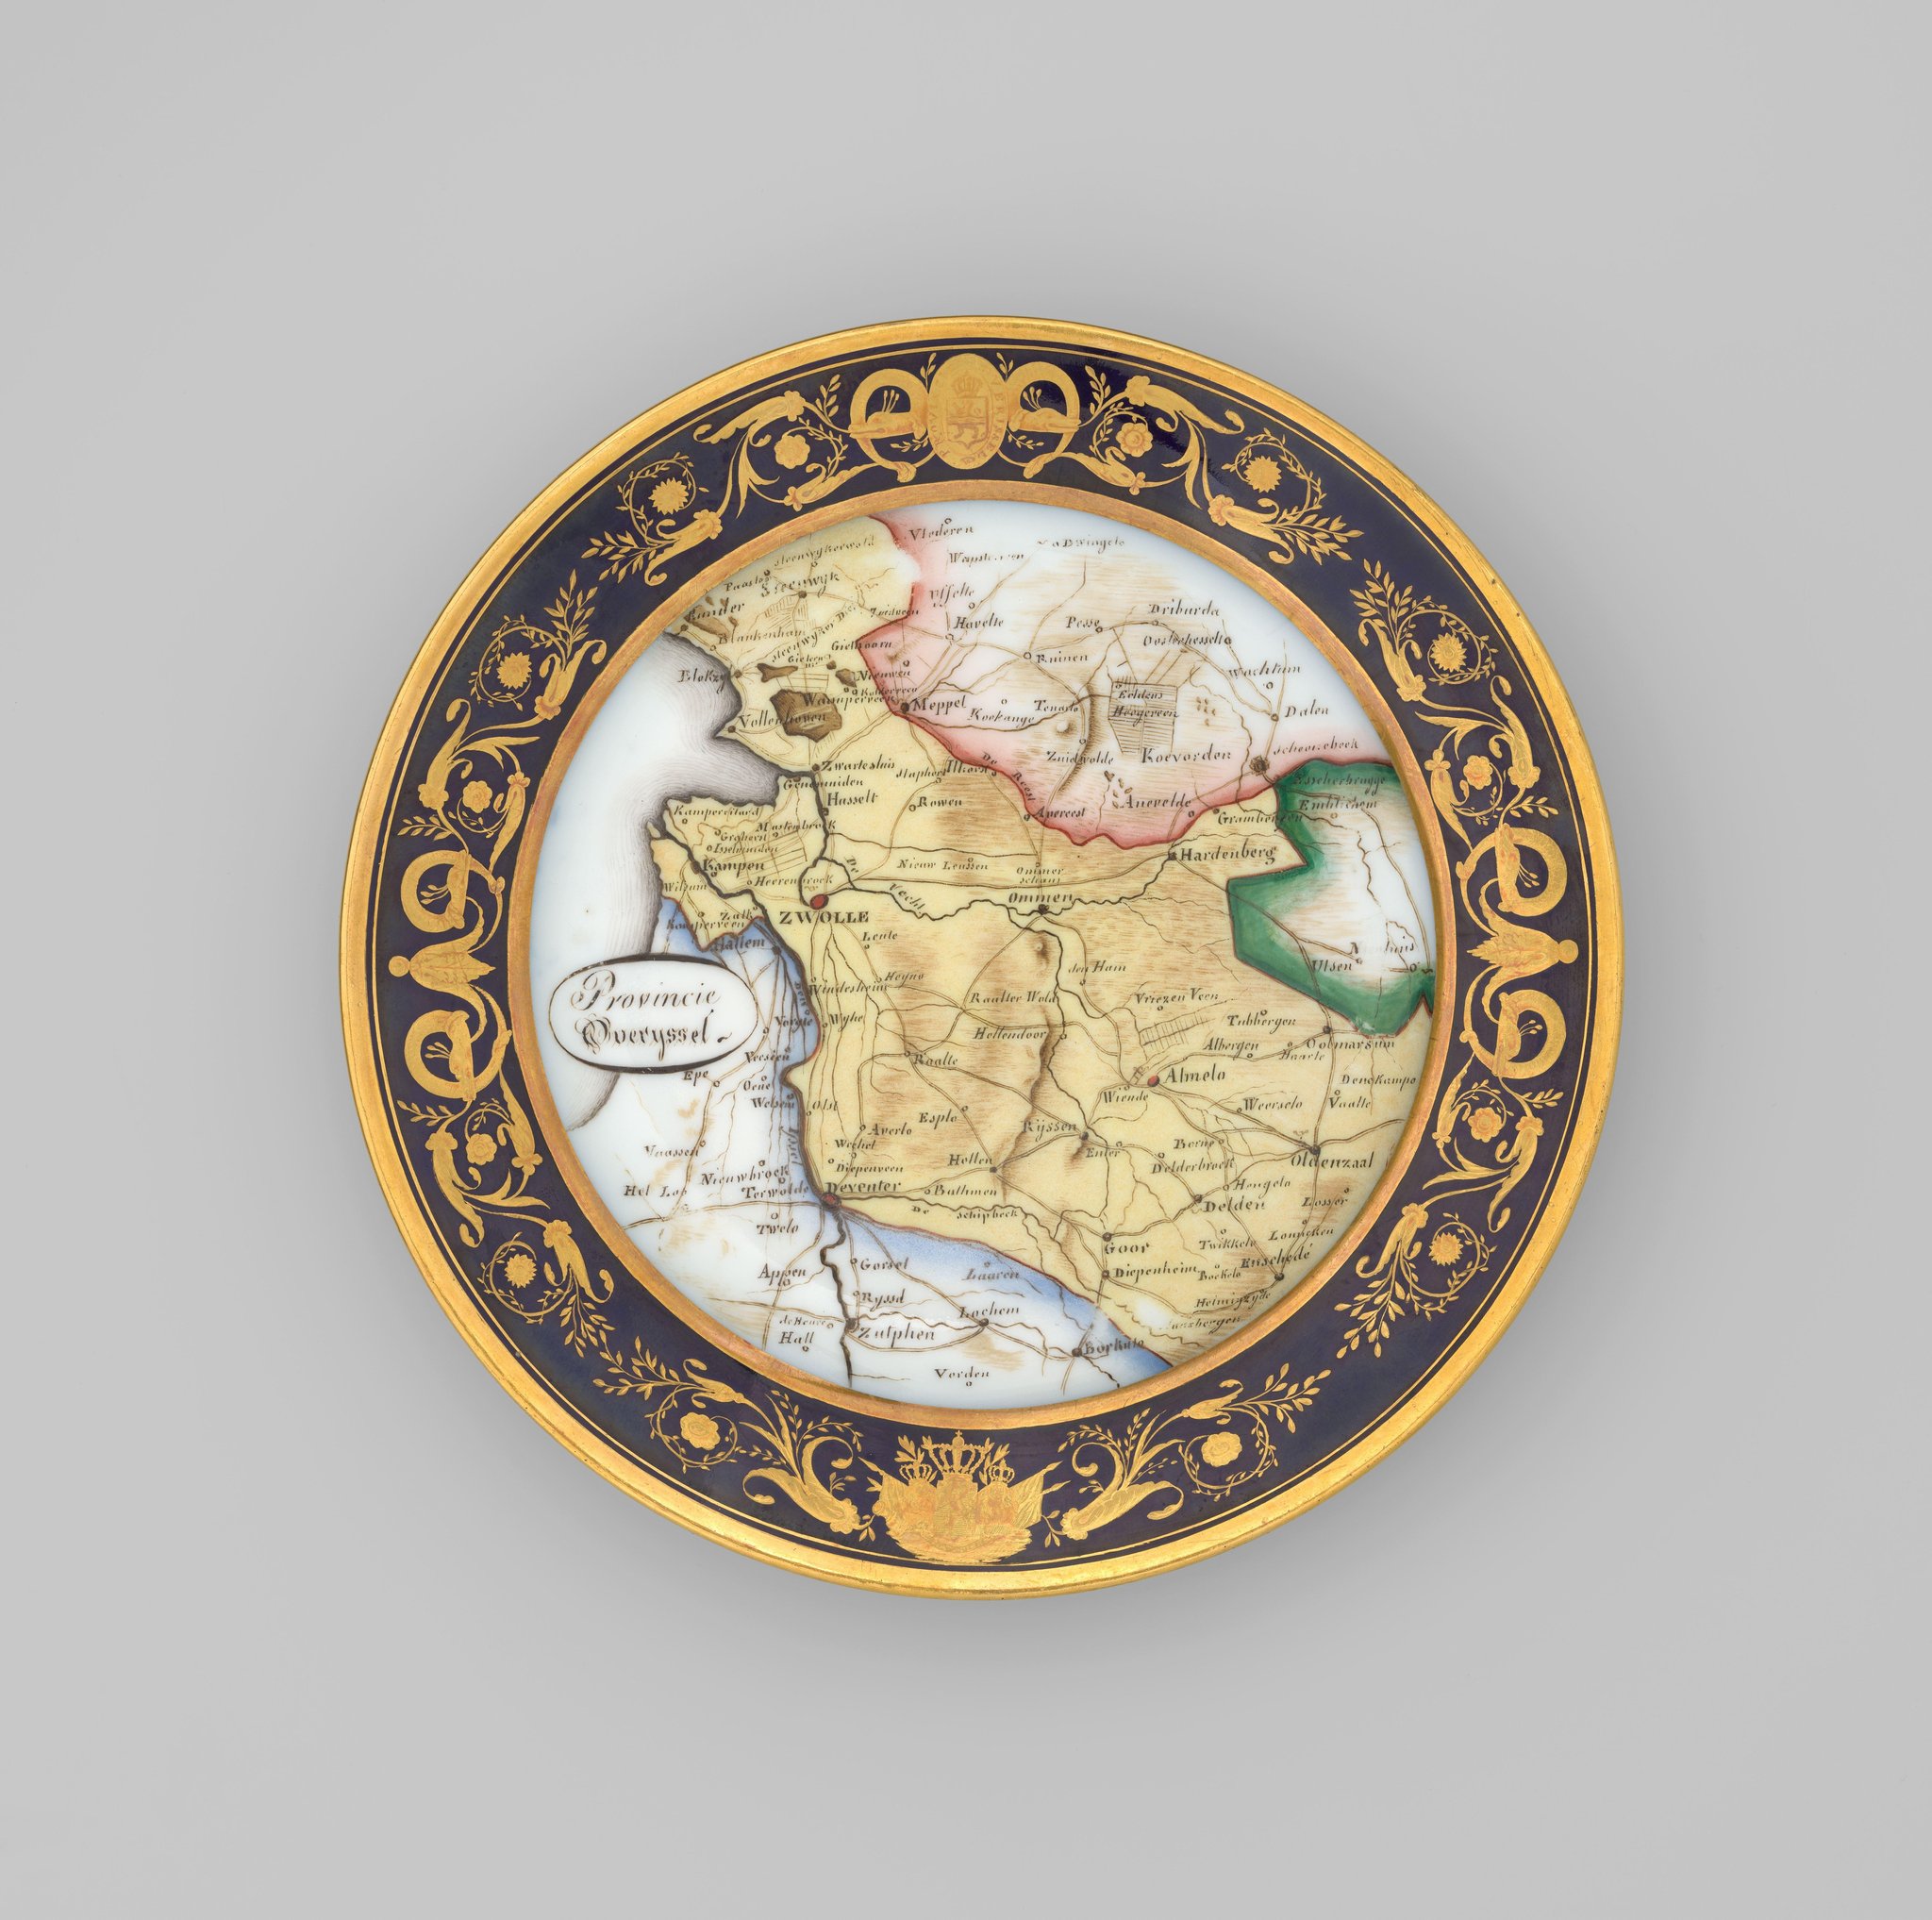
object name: plate dish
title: 18 plates, each decorated with a Netherlandish province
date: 1822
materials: glaze, gold, paint, porcelain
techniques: firing, gilding, turning, vitrification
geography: paris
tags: verenigd koninkrijk der nederlanden, overijssel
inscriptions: monogram and date: ‘R. D. 1822’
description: These plates reflect the period when the Netherlands and Belgium together formed the United Kingdom of the Netherlands (1815-1830). The kingdom consisted of 17 provinces plus the grand duchy of Luxembourg. The gold decoration is in the Neoclassical style. On the upper edge are the arms of the kingdom, on the lower border those of each province. Today the Netherlands consists of 12 provinces.